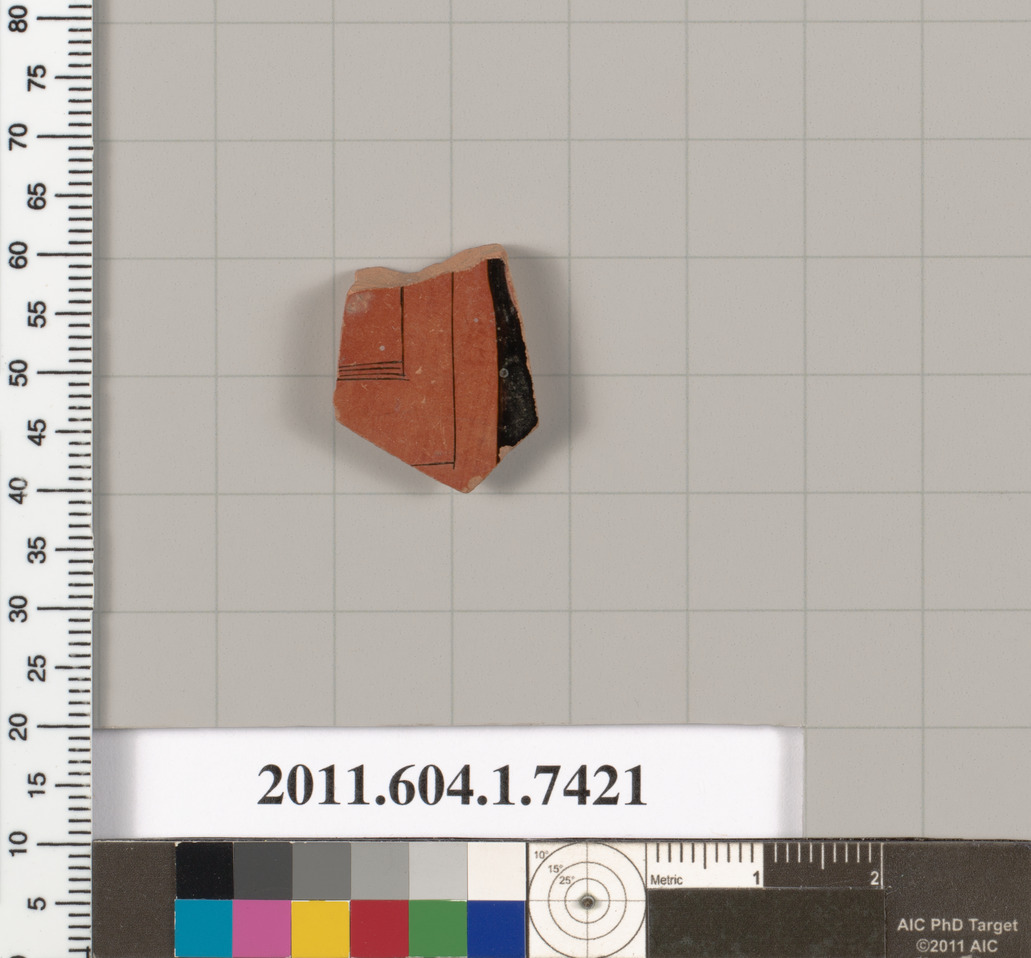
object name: kylix fragment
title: Terracotta fragment of a kylix (drinking cup)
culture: greek, attic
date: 490-470 BCE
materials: terracotta